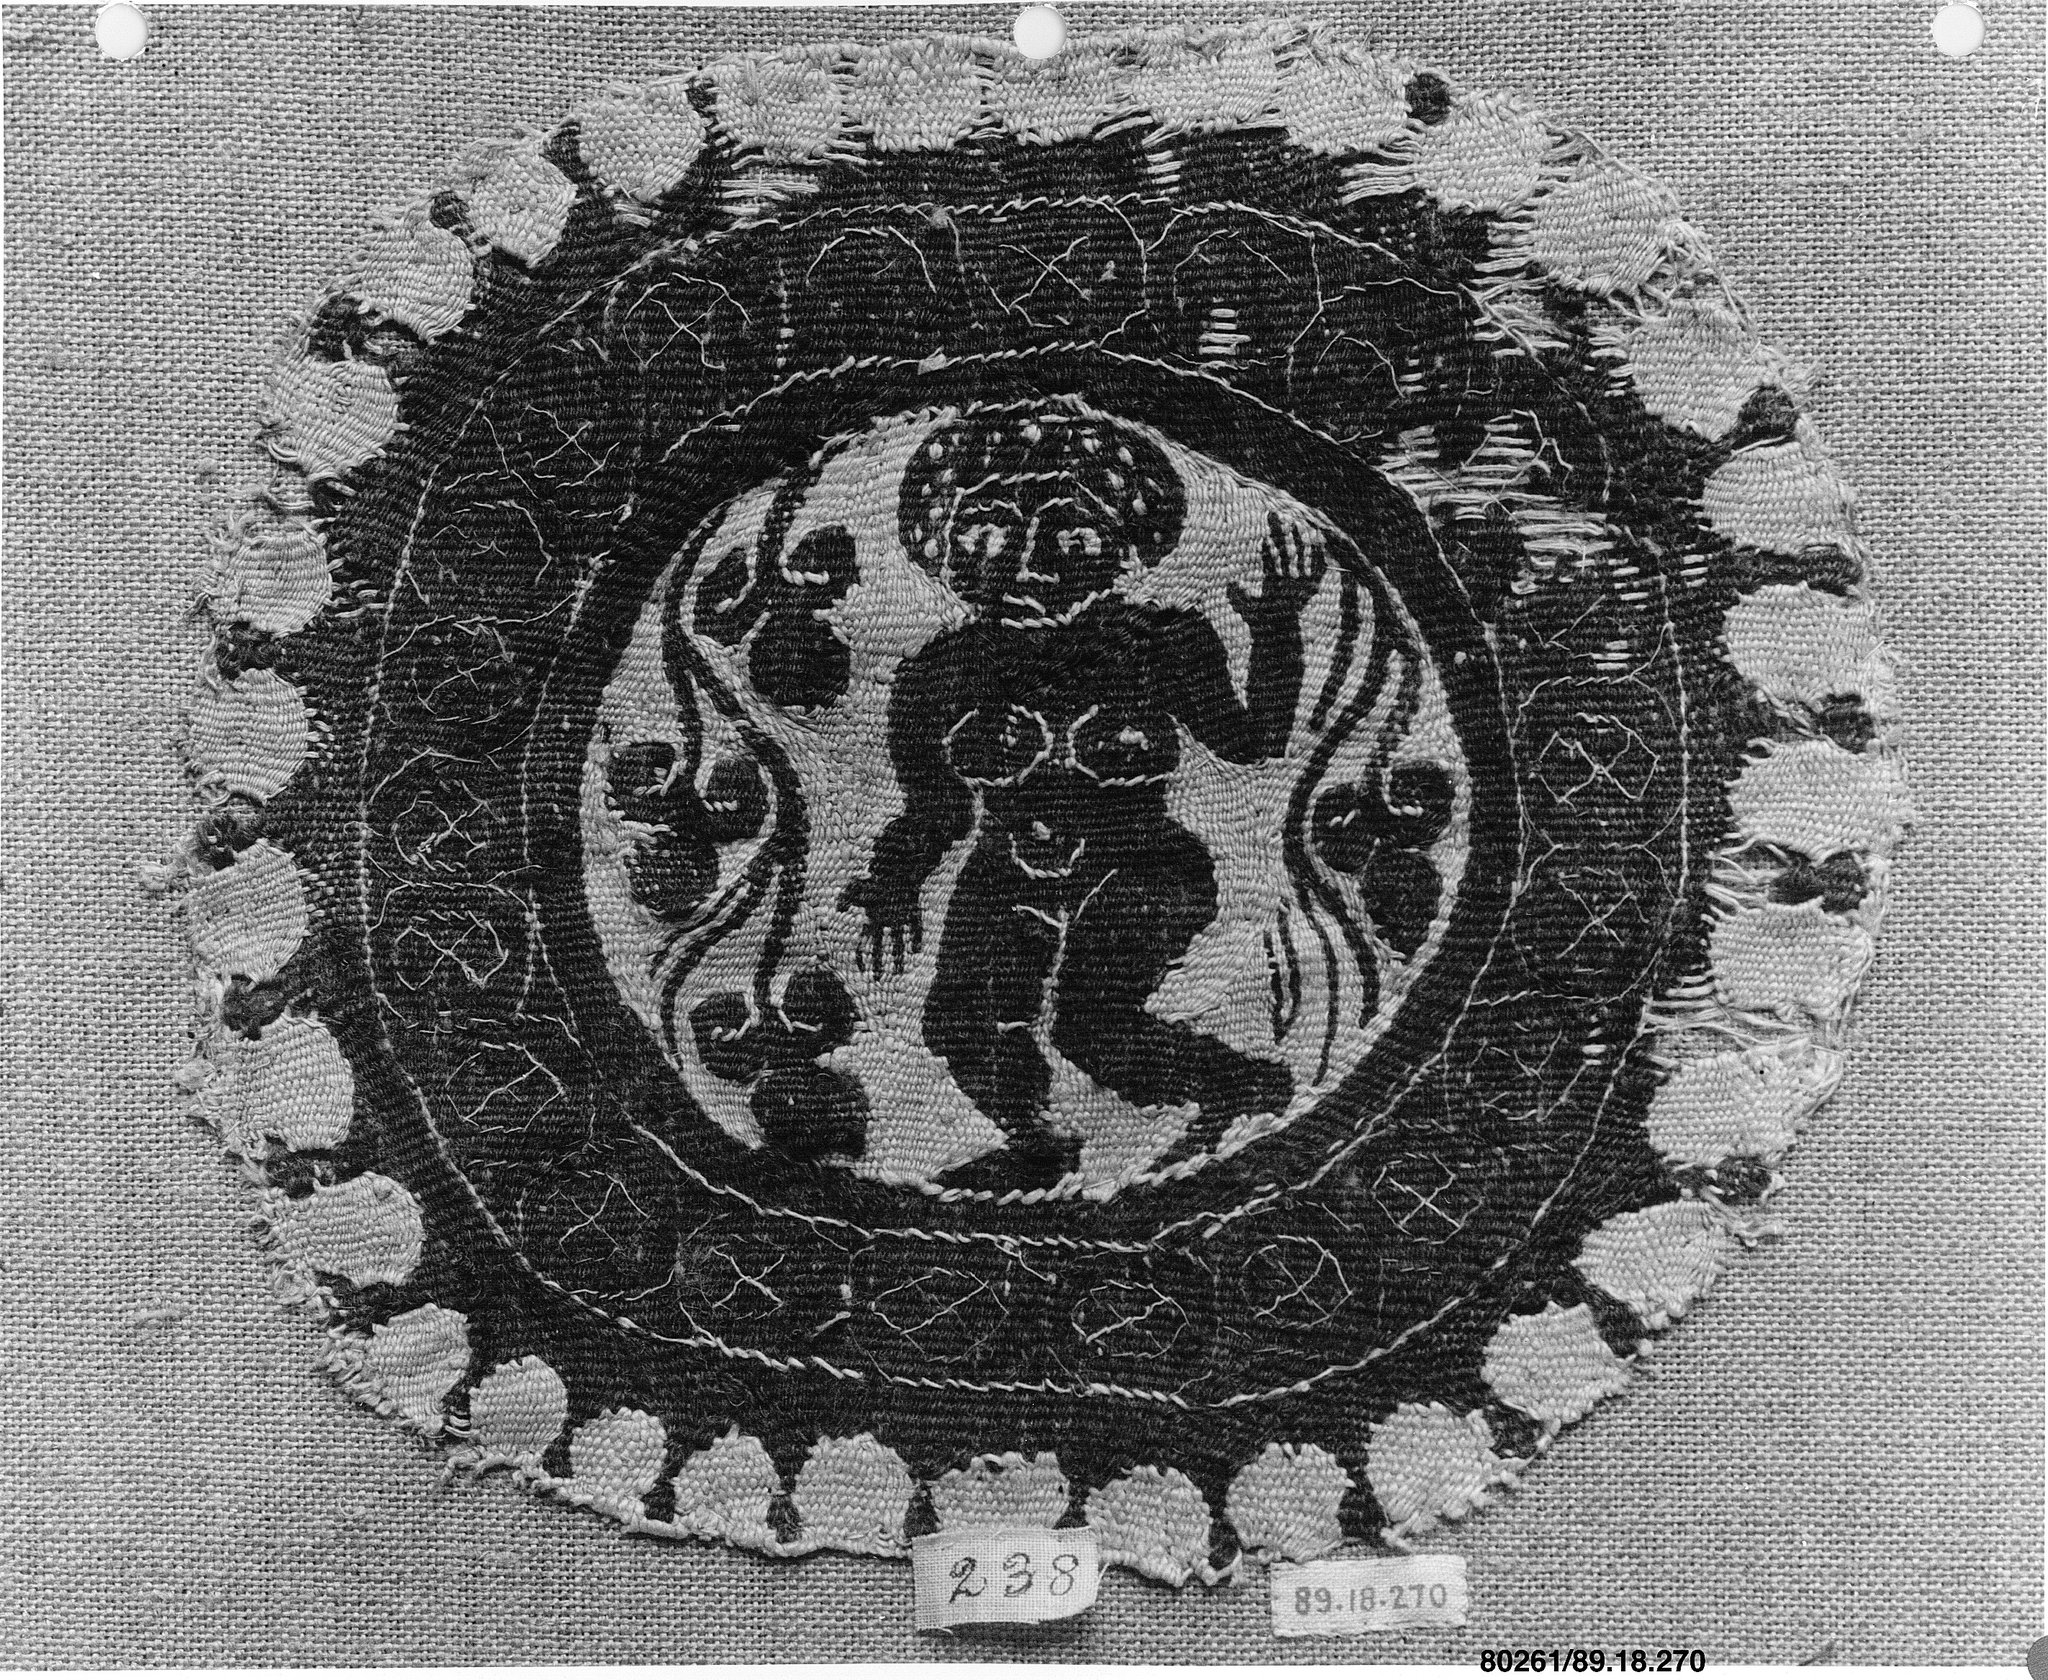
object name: textile fragment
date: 201-400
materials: linen, wool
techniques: weave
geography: egypt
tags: female nudes